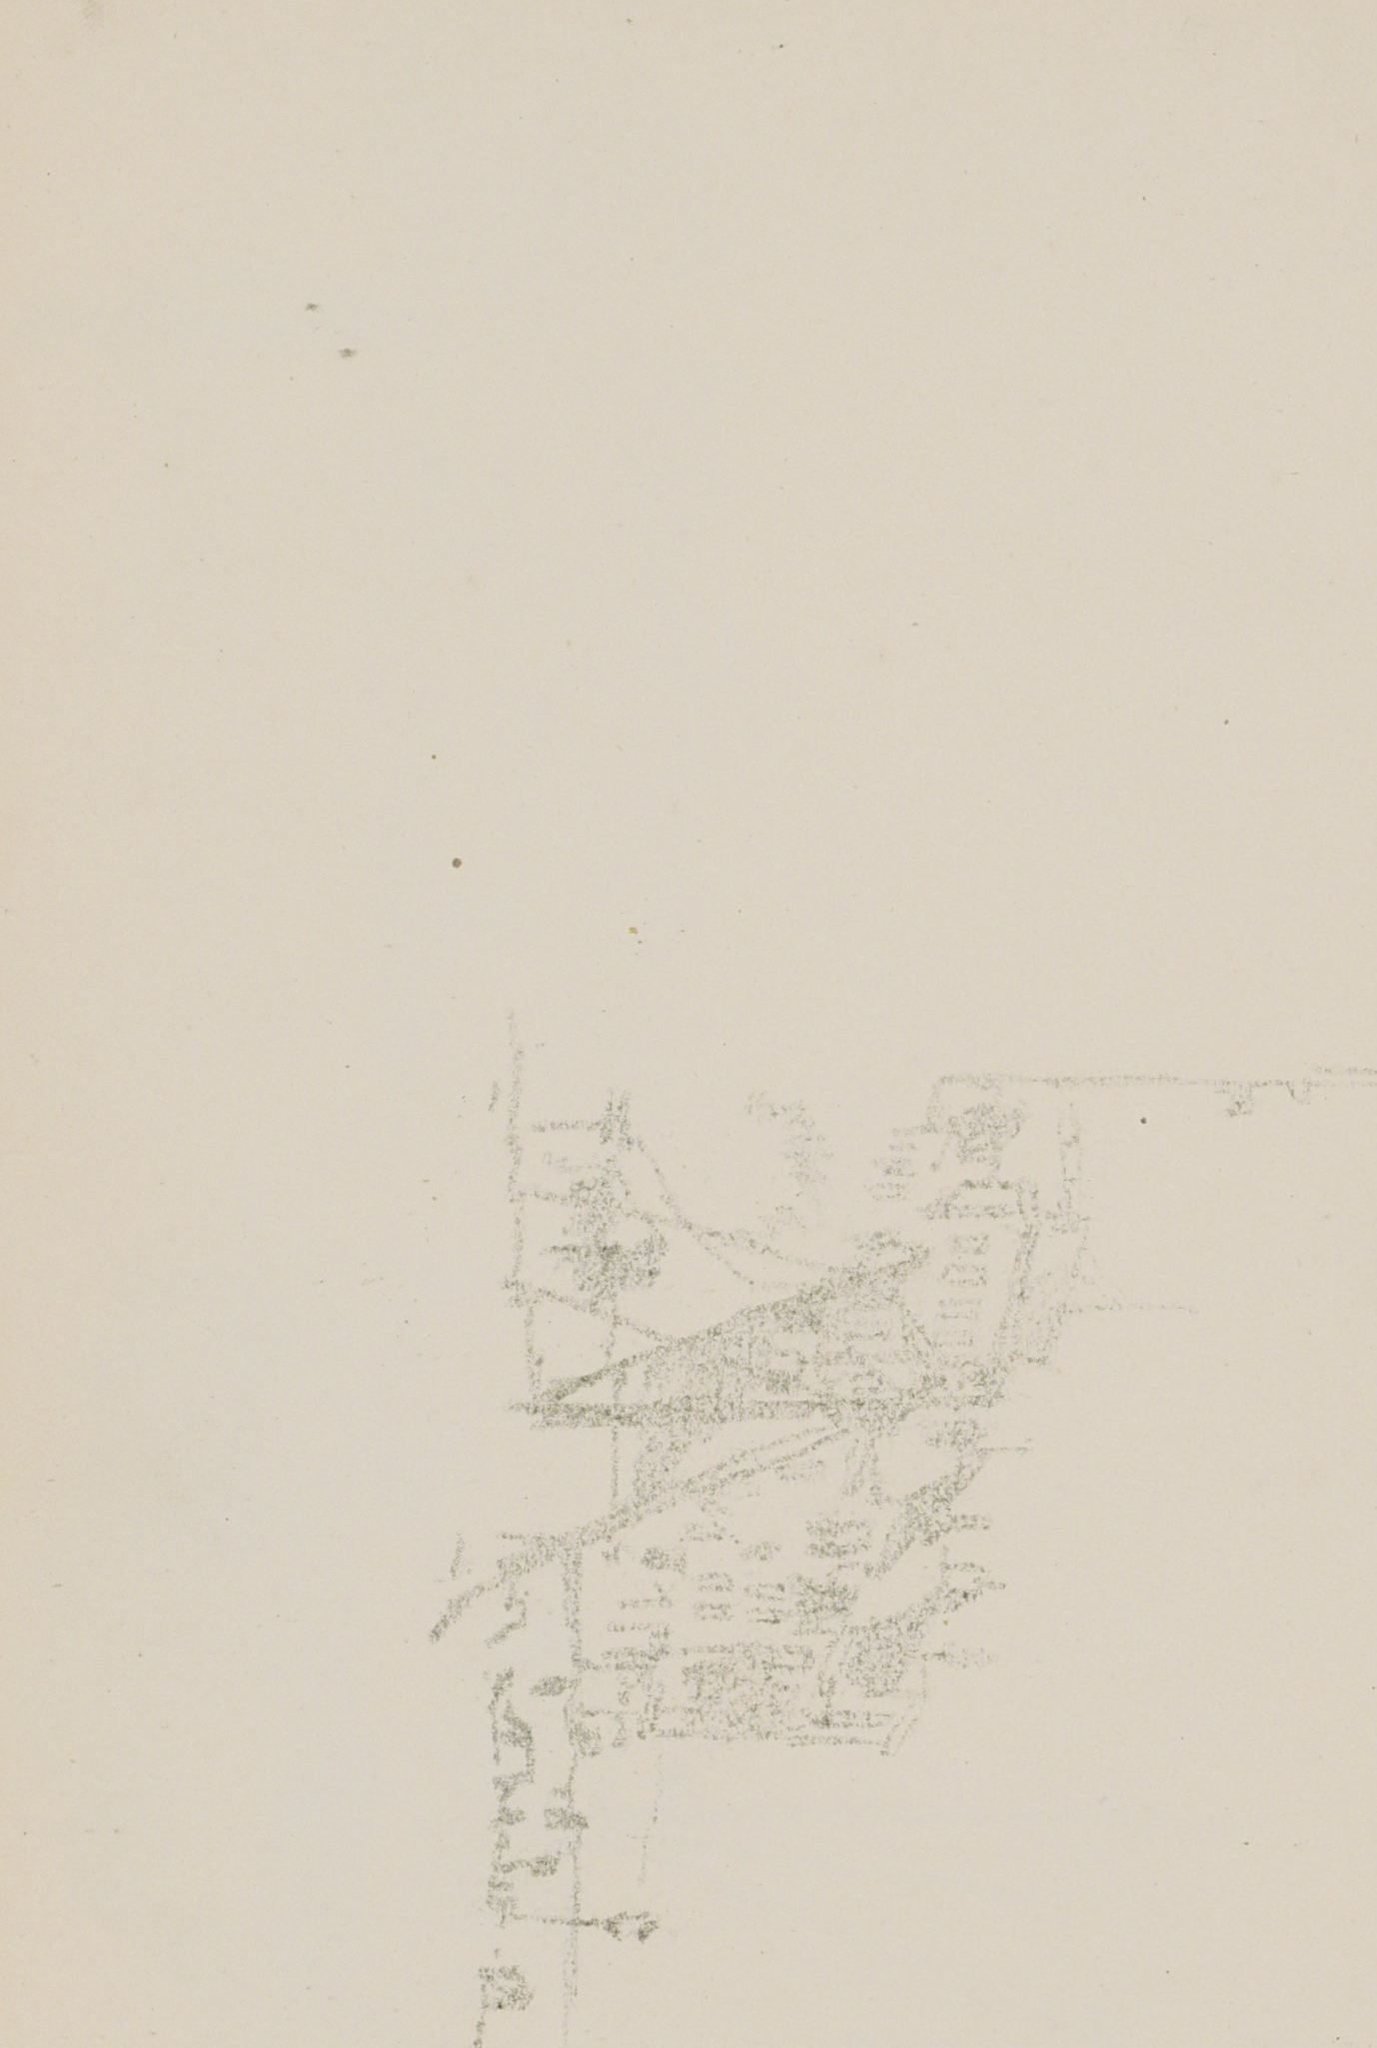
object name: sketchbook leaf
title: Abklatsch van de krijttekening op pagina 17 recto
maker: cornelis vreedenburgh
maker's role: draughtsman, print maker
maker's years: 1880-1946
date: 1890-1946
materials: paper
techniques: printmaking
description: Blad 16 verso uit een schetsboek met 47 bladen.